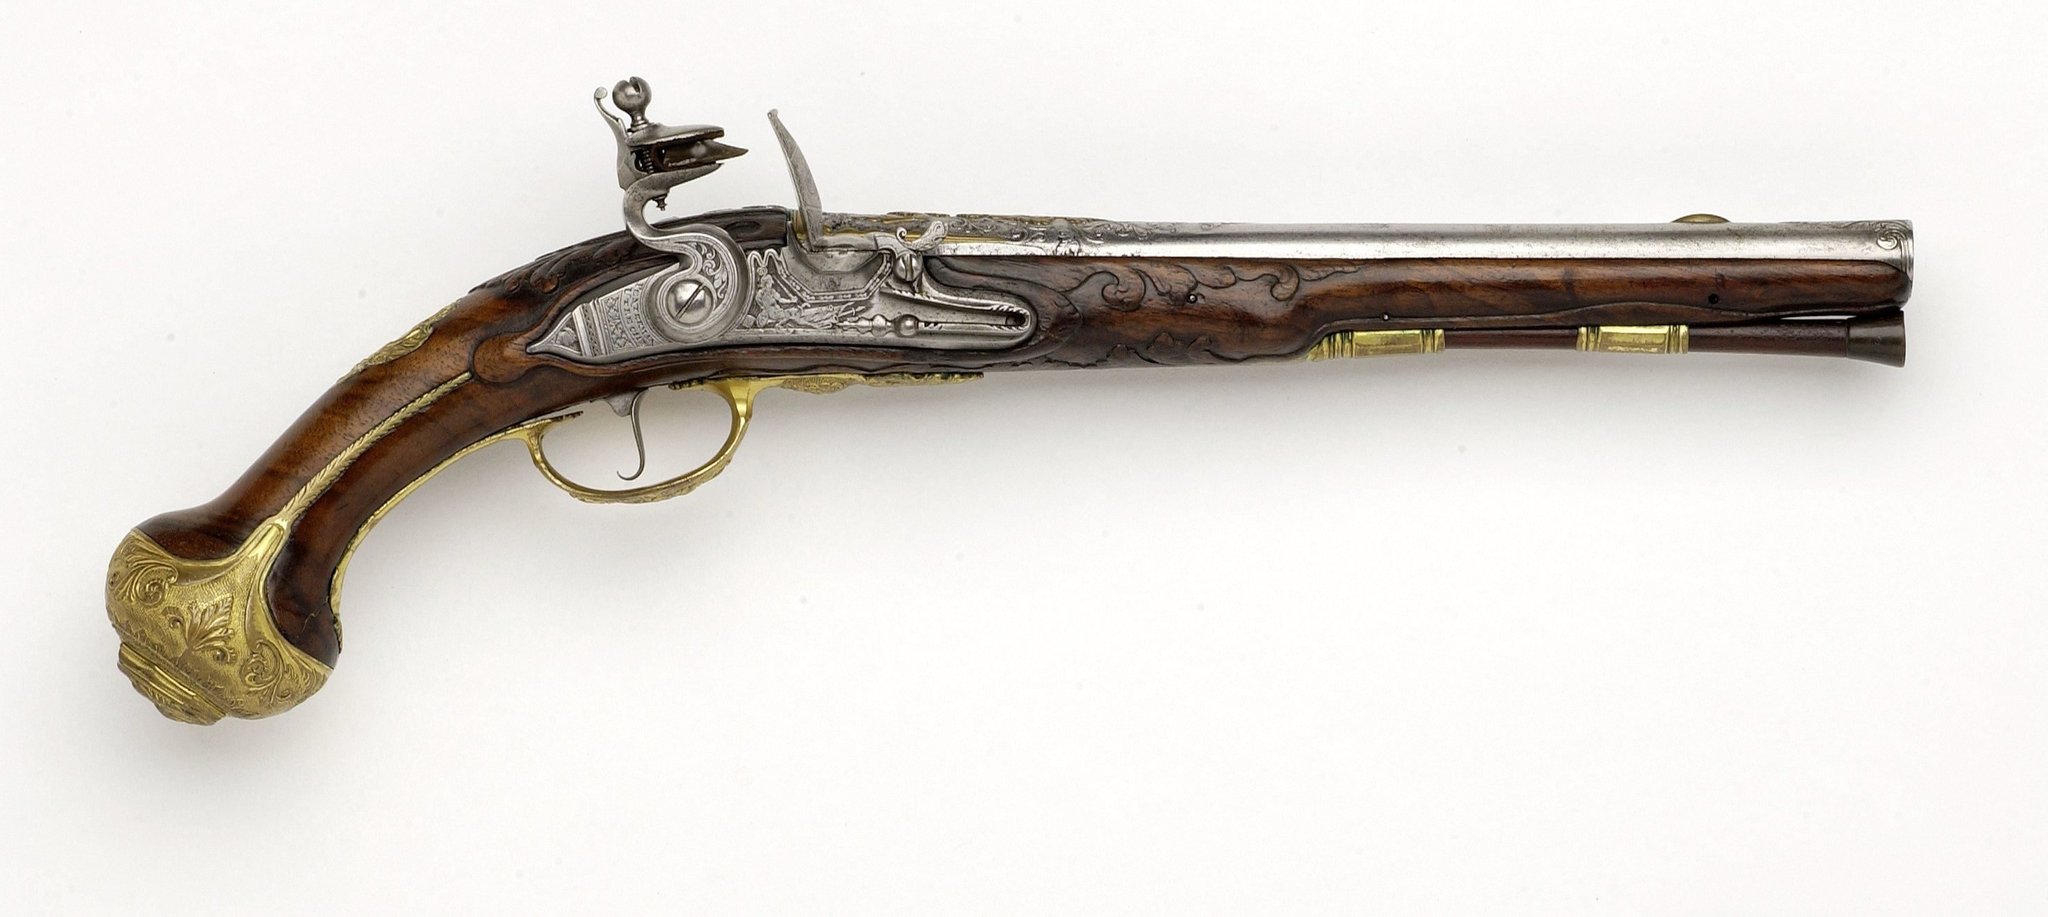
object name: flintlock pistol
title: Vuursteenpistool/ vuursteengeweer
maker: barend penterman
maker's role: geweermaker, pistoolmaker, vuursteenslotmaker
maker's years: -1723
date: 1710-1720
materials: brass, stone, horn, iron, wood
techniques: printing, cutting, engraving, gilding, granulation, relief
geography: utrecht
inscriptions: mark: ‘H’, mark, inscription: ‘PENTERMAN // UTRECHT’